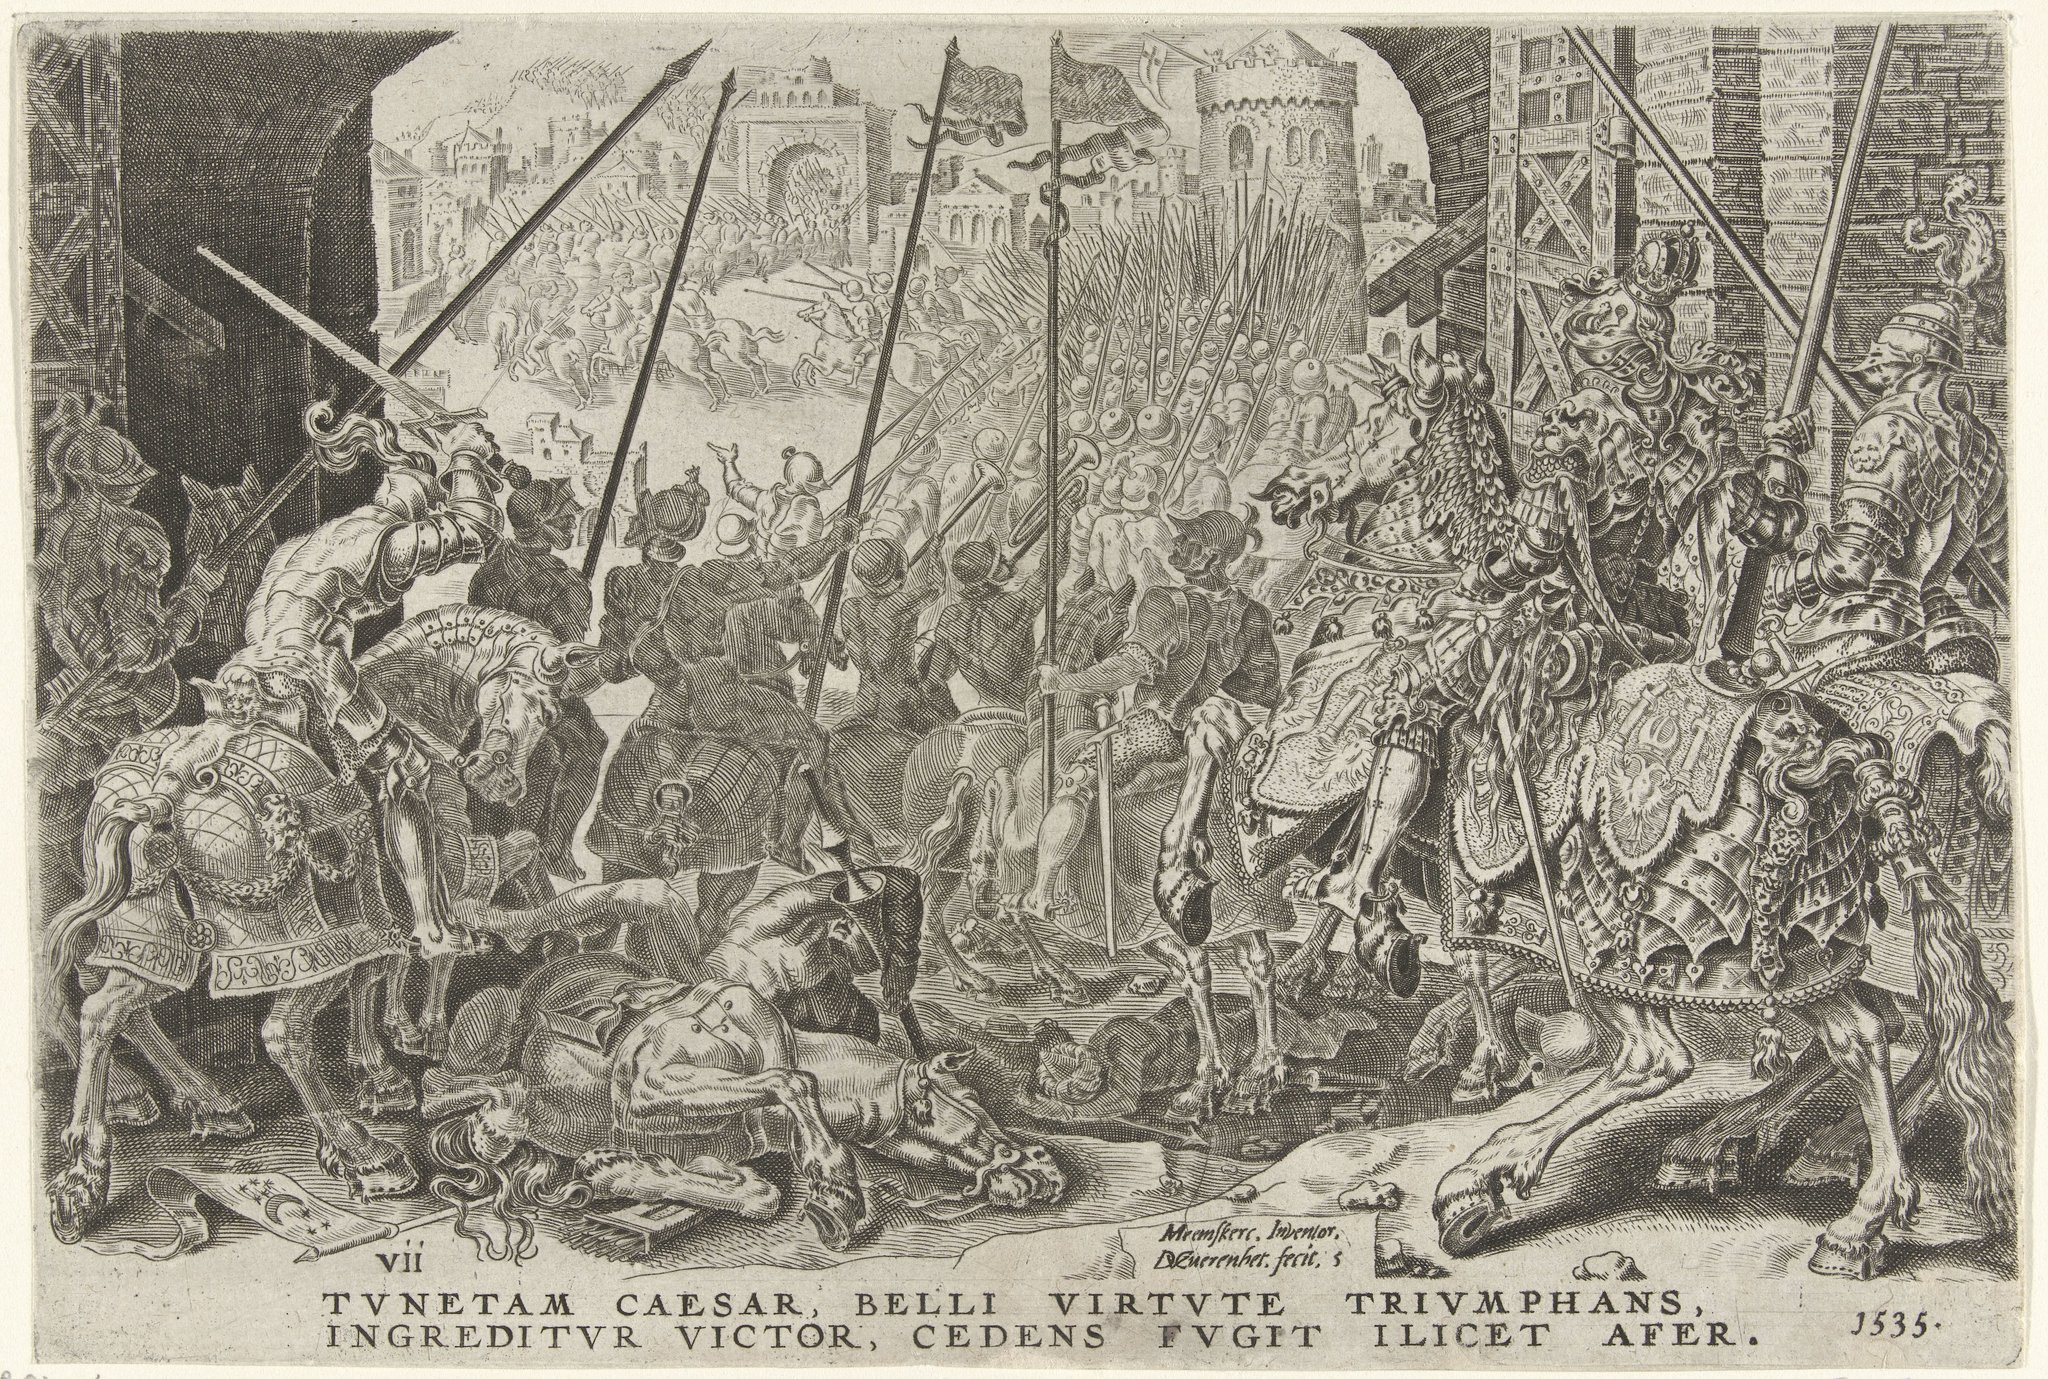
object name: history print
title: Inname van Tunis, 1535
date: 1555-1556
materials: paper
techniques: engraving, etching, letterpress printing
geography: haarlem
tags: ghent, charles v (holy roman emperor and king of spain)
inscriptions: collector's mark: Lugt 2228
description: Verovering van Tunis (1535). De keizerlijke troepen trekken de stad binnen. Rechts Karel V te paard. De prent maakt deel uit van een twaalfdelige serie over de overwinningen van Karel V. Hij heeft een onderschrift met een Latijnse tekst.